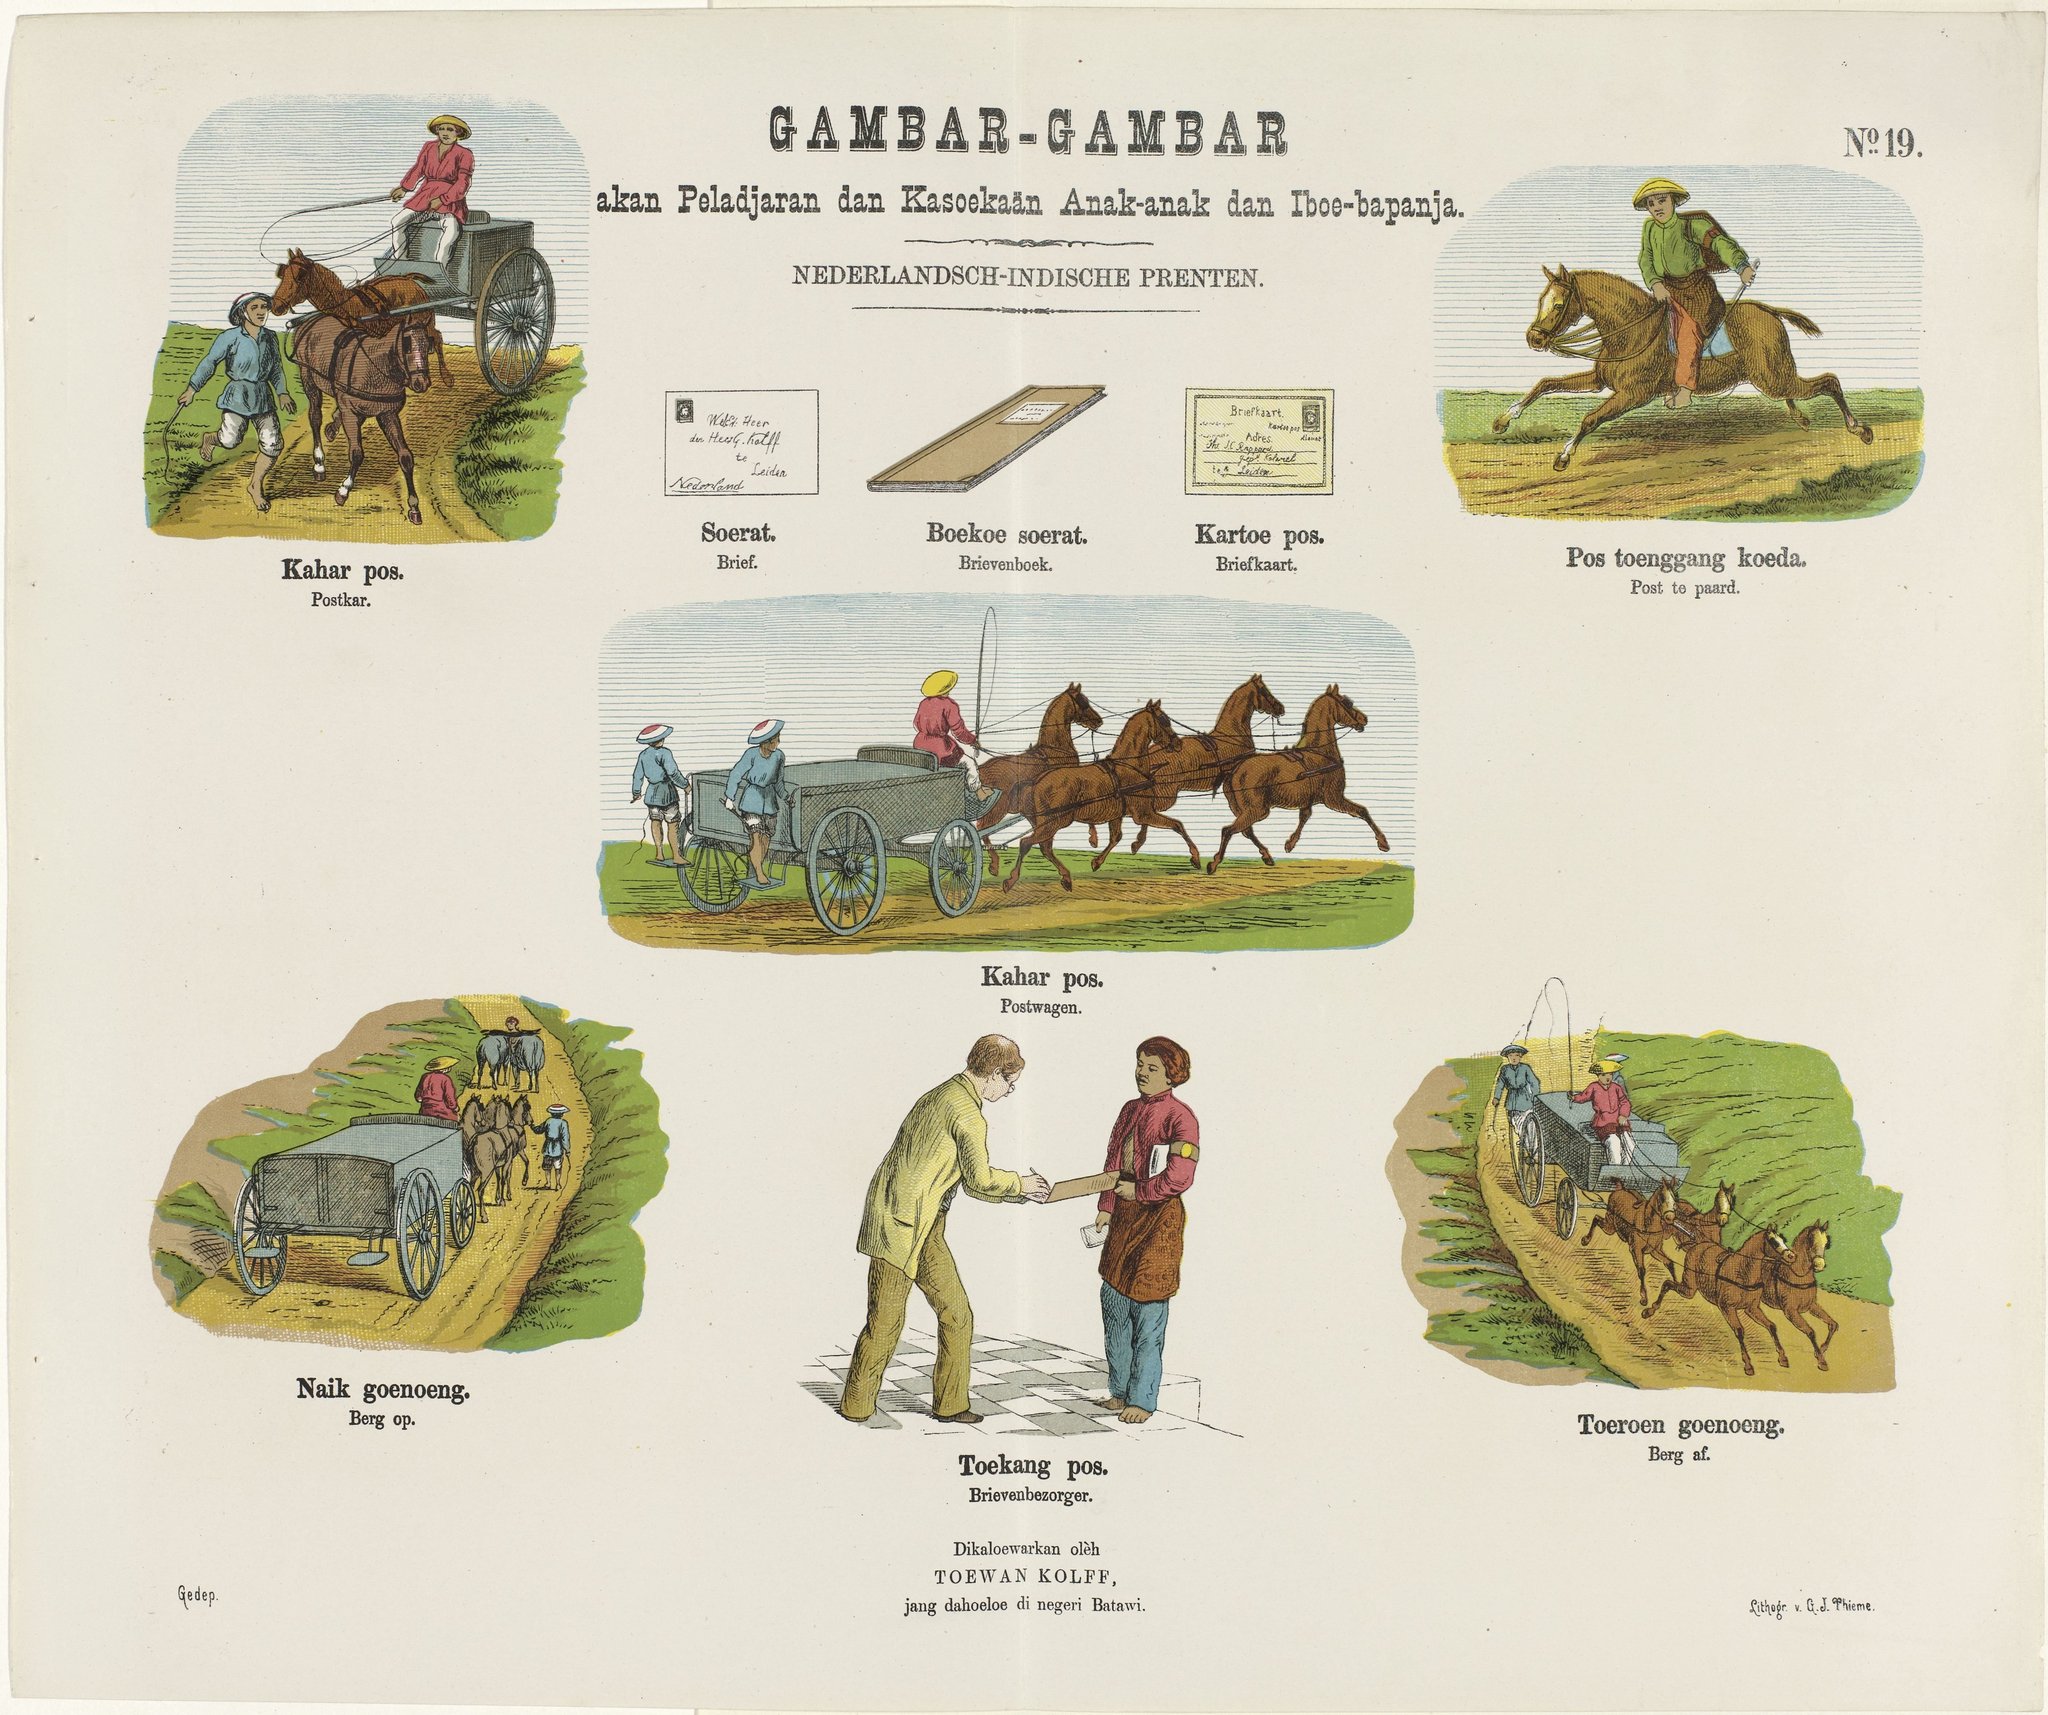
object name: print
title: Post bezorgen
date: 1868-1881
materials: paper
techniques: lithograph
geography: arnhem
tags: postal service, asiatic races and peoples, mail-coach, postcard, picture-postcard, postman, letter, envelope, dutch east indies, the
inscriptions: collector's mark: Lugt 2760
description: Blad met negen voorstellingen over post bezorgen in de voormalige kolonie Nederlands-Indië. Onder elke afbeelding een onderschrift in het Maleis en het Nederlands. Genummerd rechtsboven: No. 19.